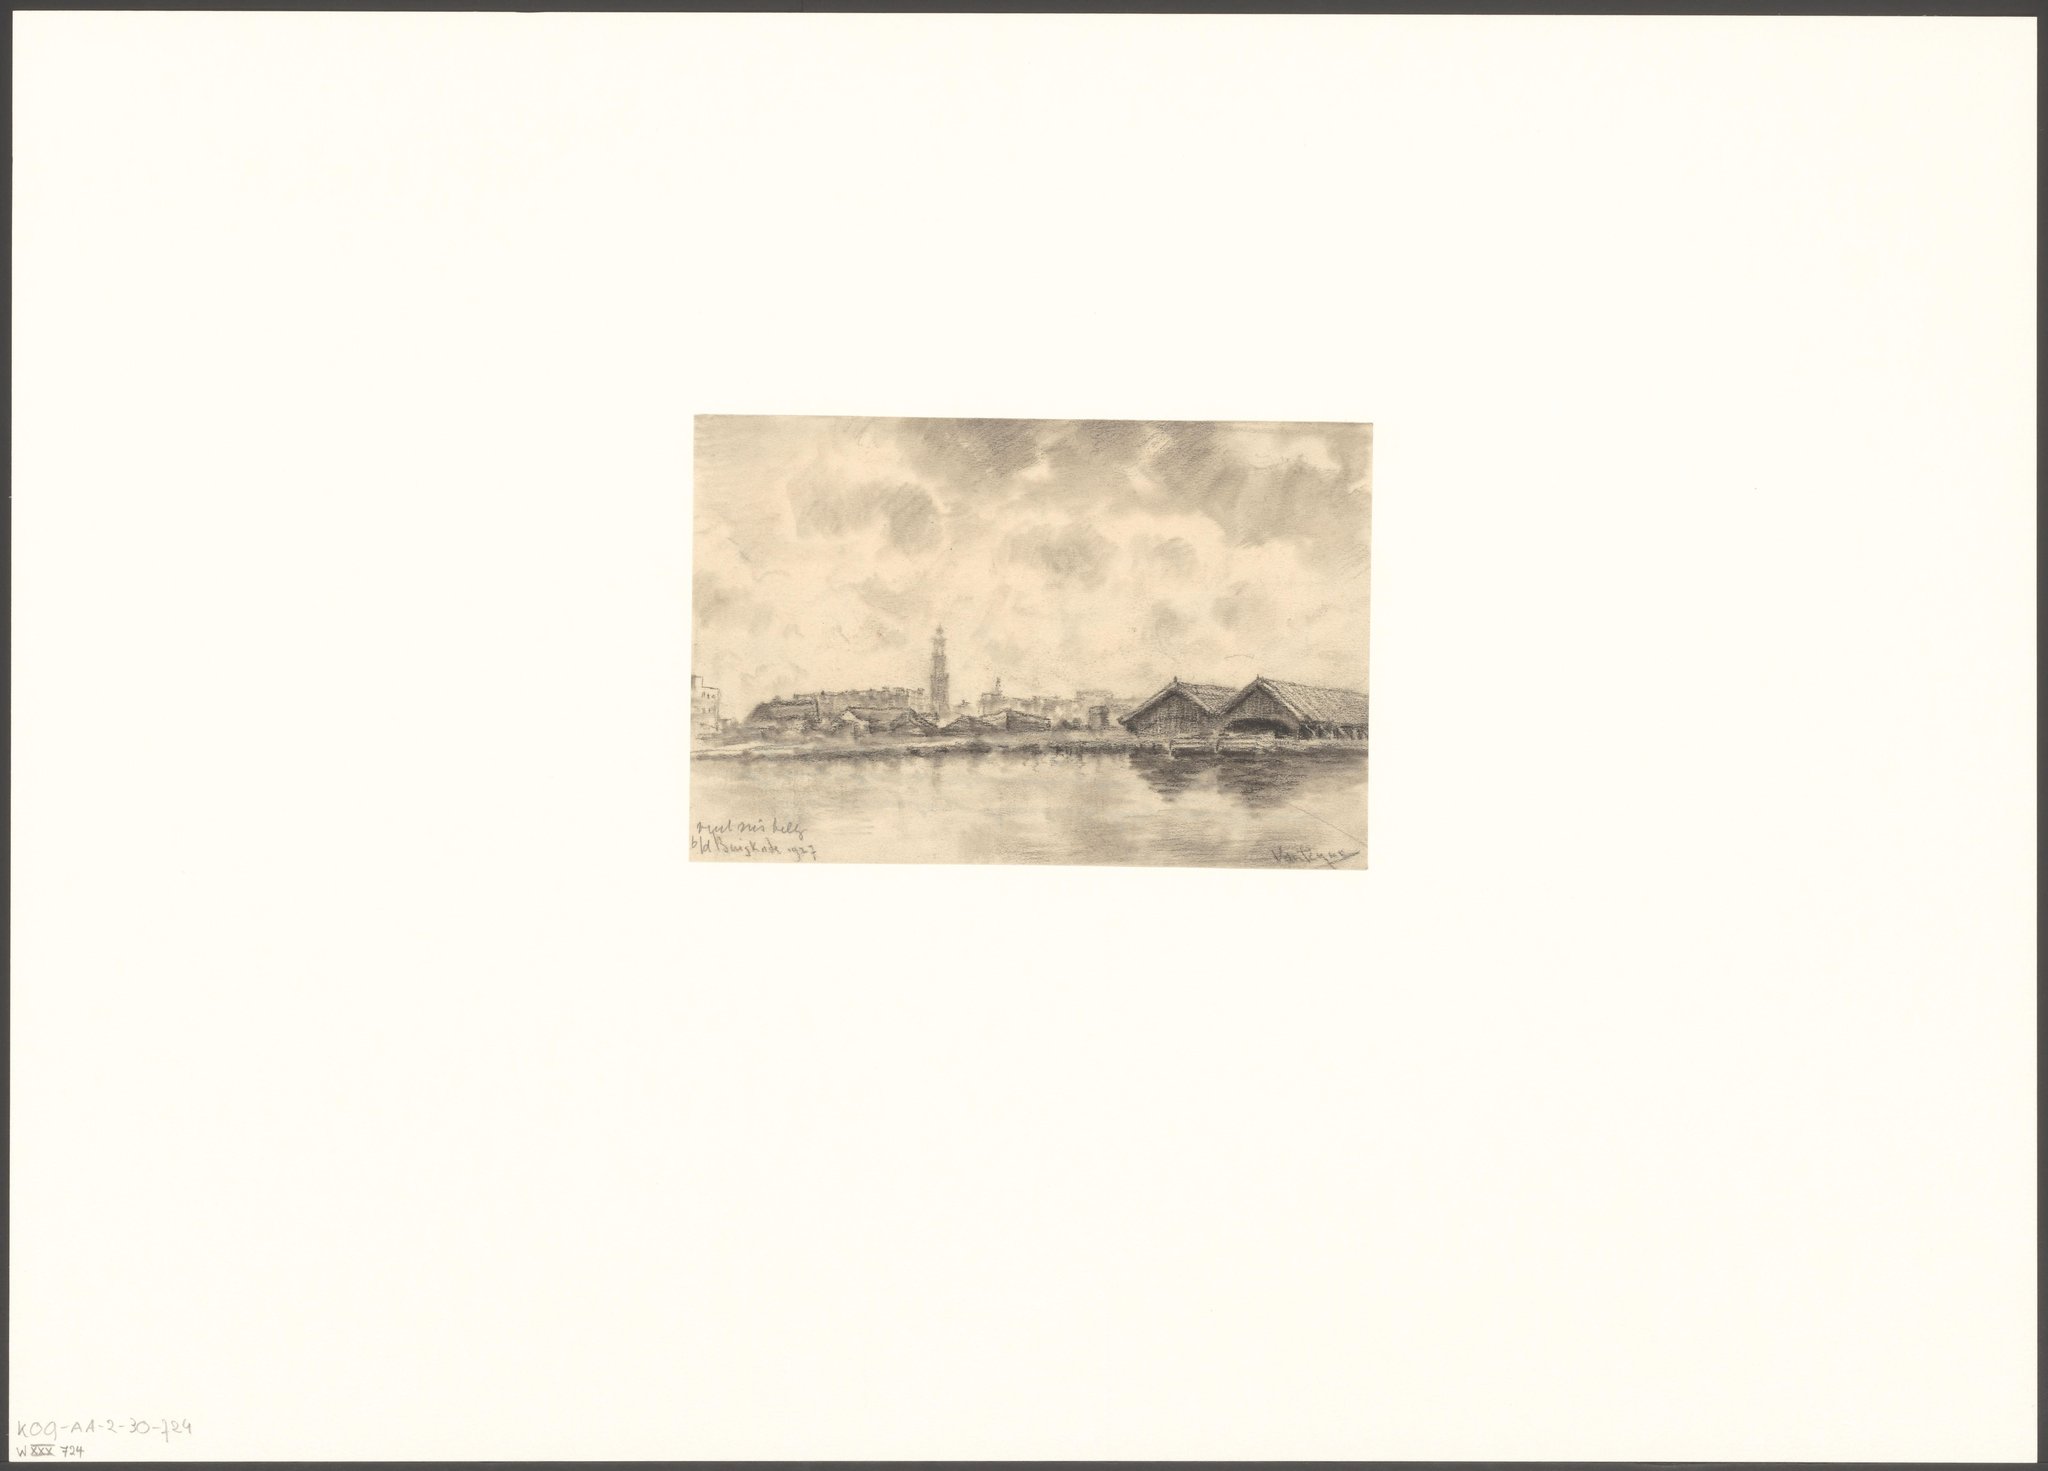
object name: drawing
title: Gezicht op de voormalige vuilnisbelt bij de Buyskade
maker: anthonie van teijn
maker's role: draughtsman, painter, print maker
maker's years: 1863-1943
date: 1907-1927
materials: chalk, paper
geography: amsterdam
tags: tower, clock tower ~ monumental adornment, city-view in general; 'veduta', canal, garbage collection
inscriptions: inscription: ‘Voormalige vuilnisbelt nabij (...) Juli 1927 / vanEck’, inscription: ‘vuilnisbelt / b/d Buiskade 1927’, collector's mark: Lugt 800a, signature: ‘VanTeyne’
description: Tekening binnen de Atlas Van Eck ingedeeld op wijknummer 30.